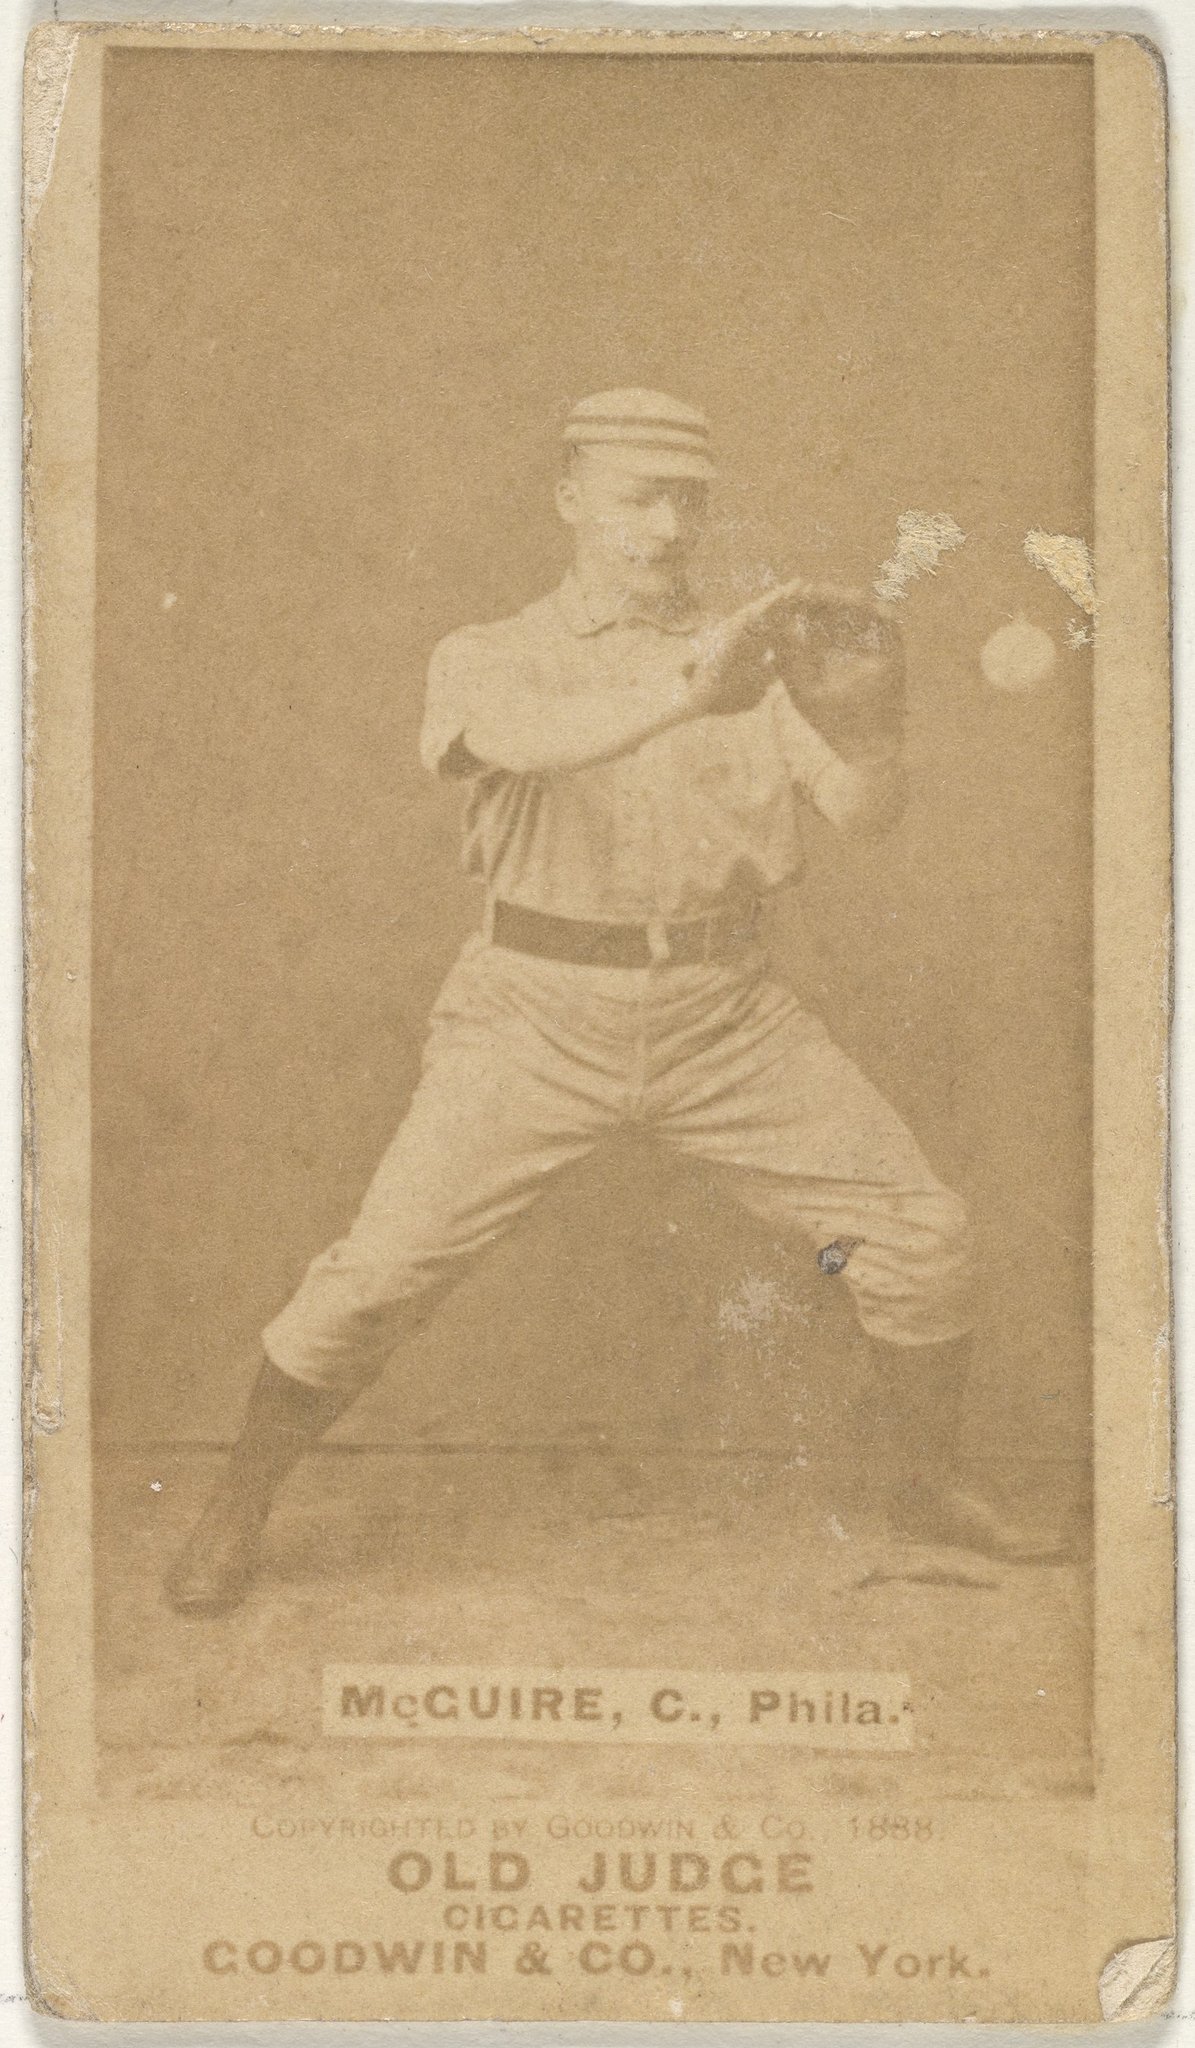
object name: baseball card, photograph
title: James Thomas "Deacon" McGuire, Catcher, Philadelphia, from the Old Judge series (N172) for Old Judge Cigarettes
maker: goodwin & company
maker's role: publisher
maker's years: 1850-1950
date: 1888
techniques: albumen silver print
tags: men,portraits,baseball,athletes